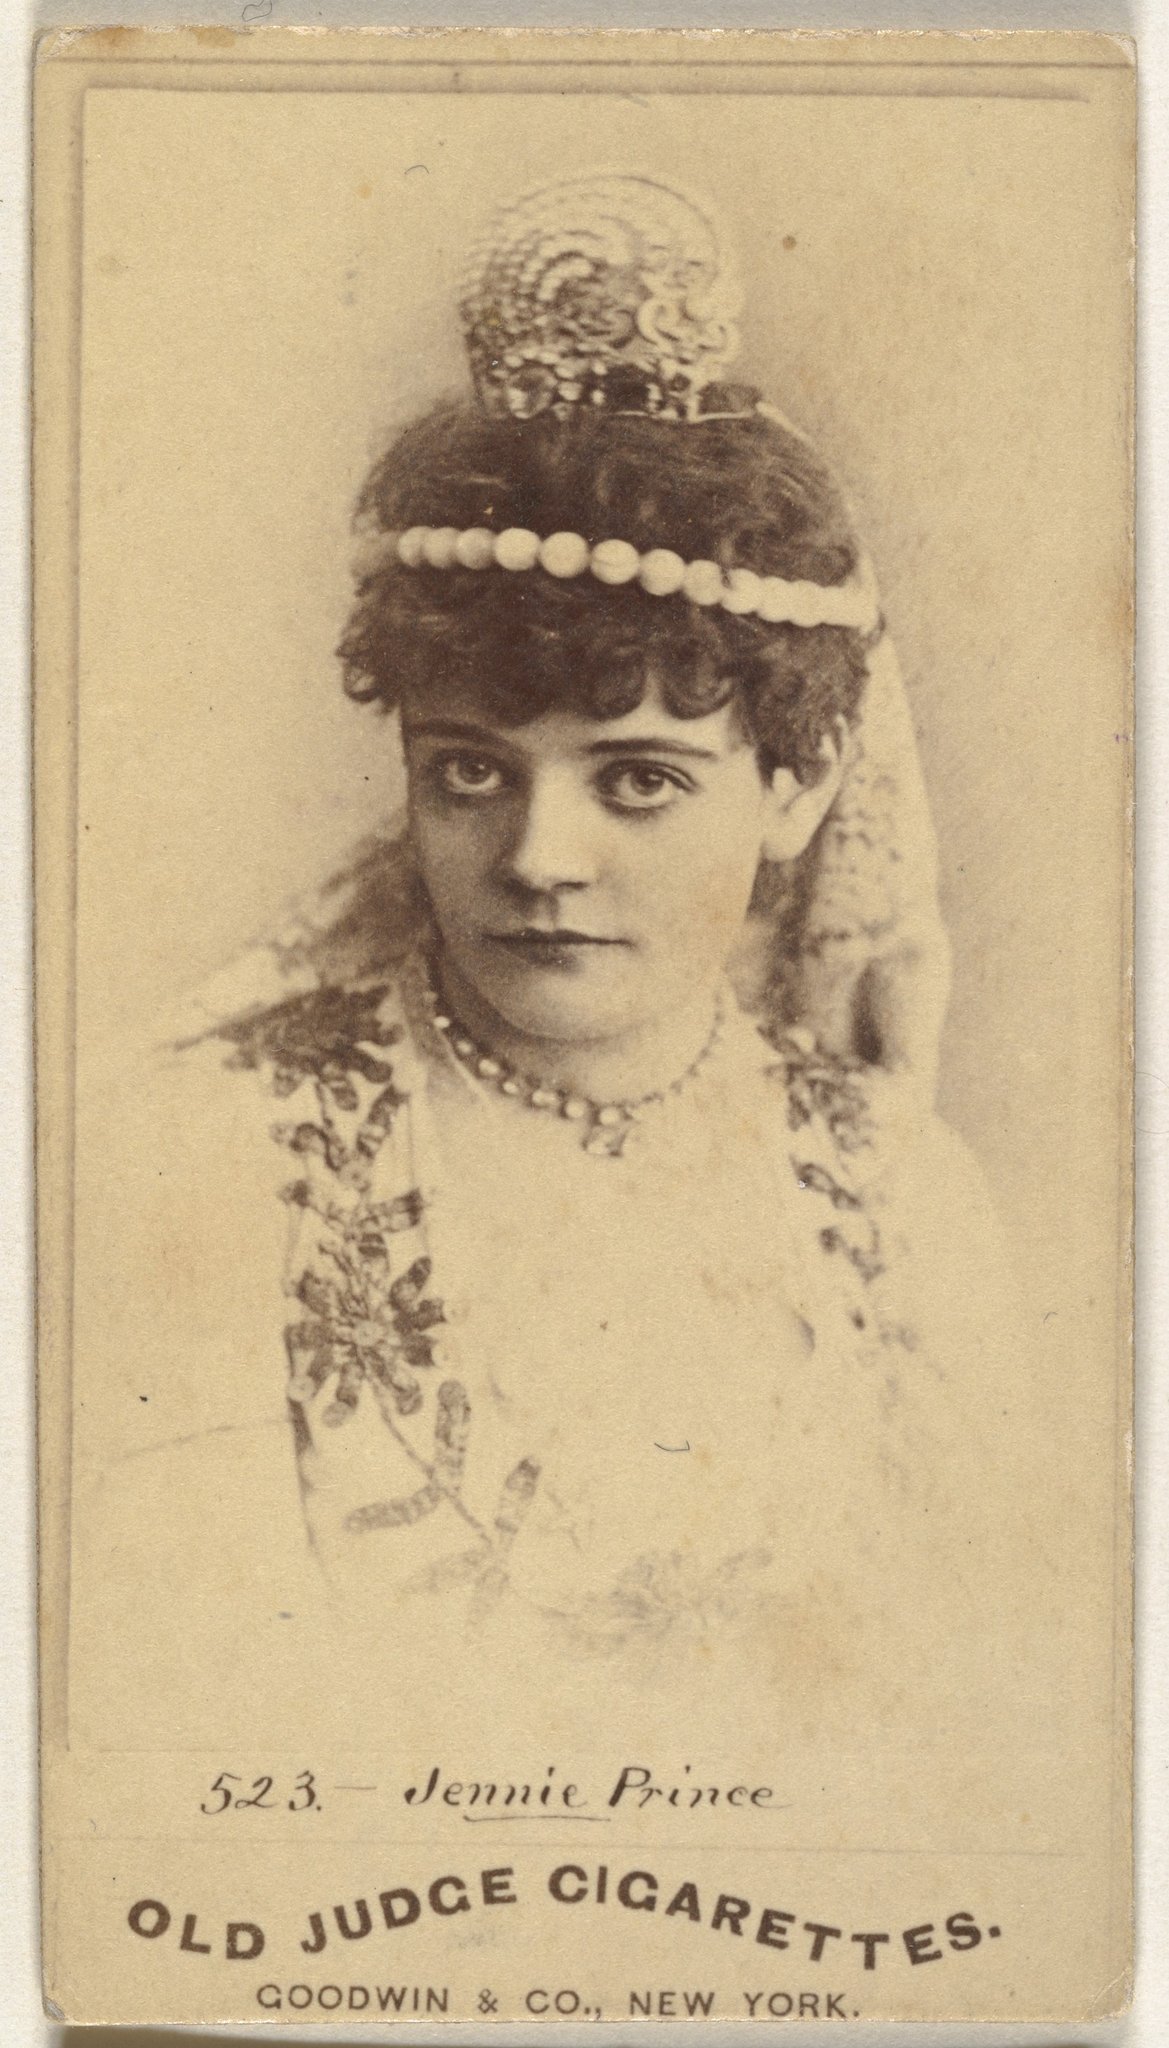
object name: photograph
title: Jennie Prince, from the Actors and Actresses series (N171) for Old Judge Cigarettes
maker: goodwin & company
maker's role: publisher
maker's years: 1850-1950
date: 1886-1890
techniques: albumen silver print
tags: portraits,women,actresses